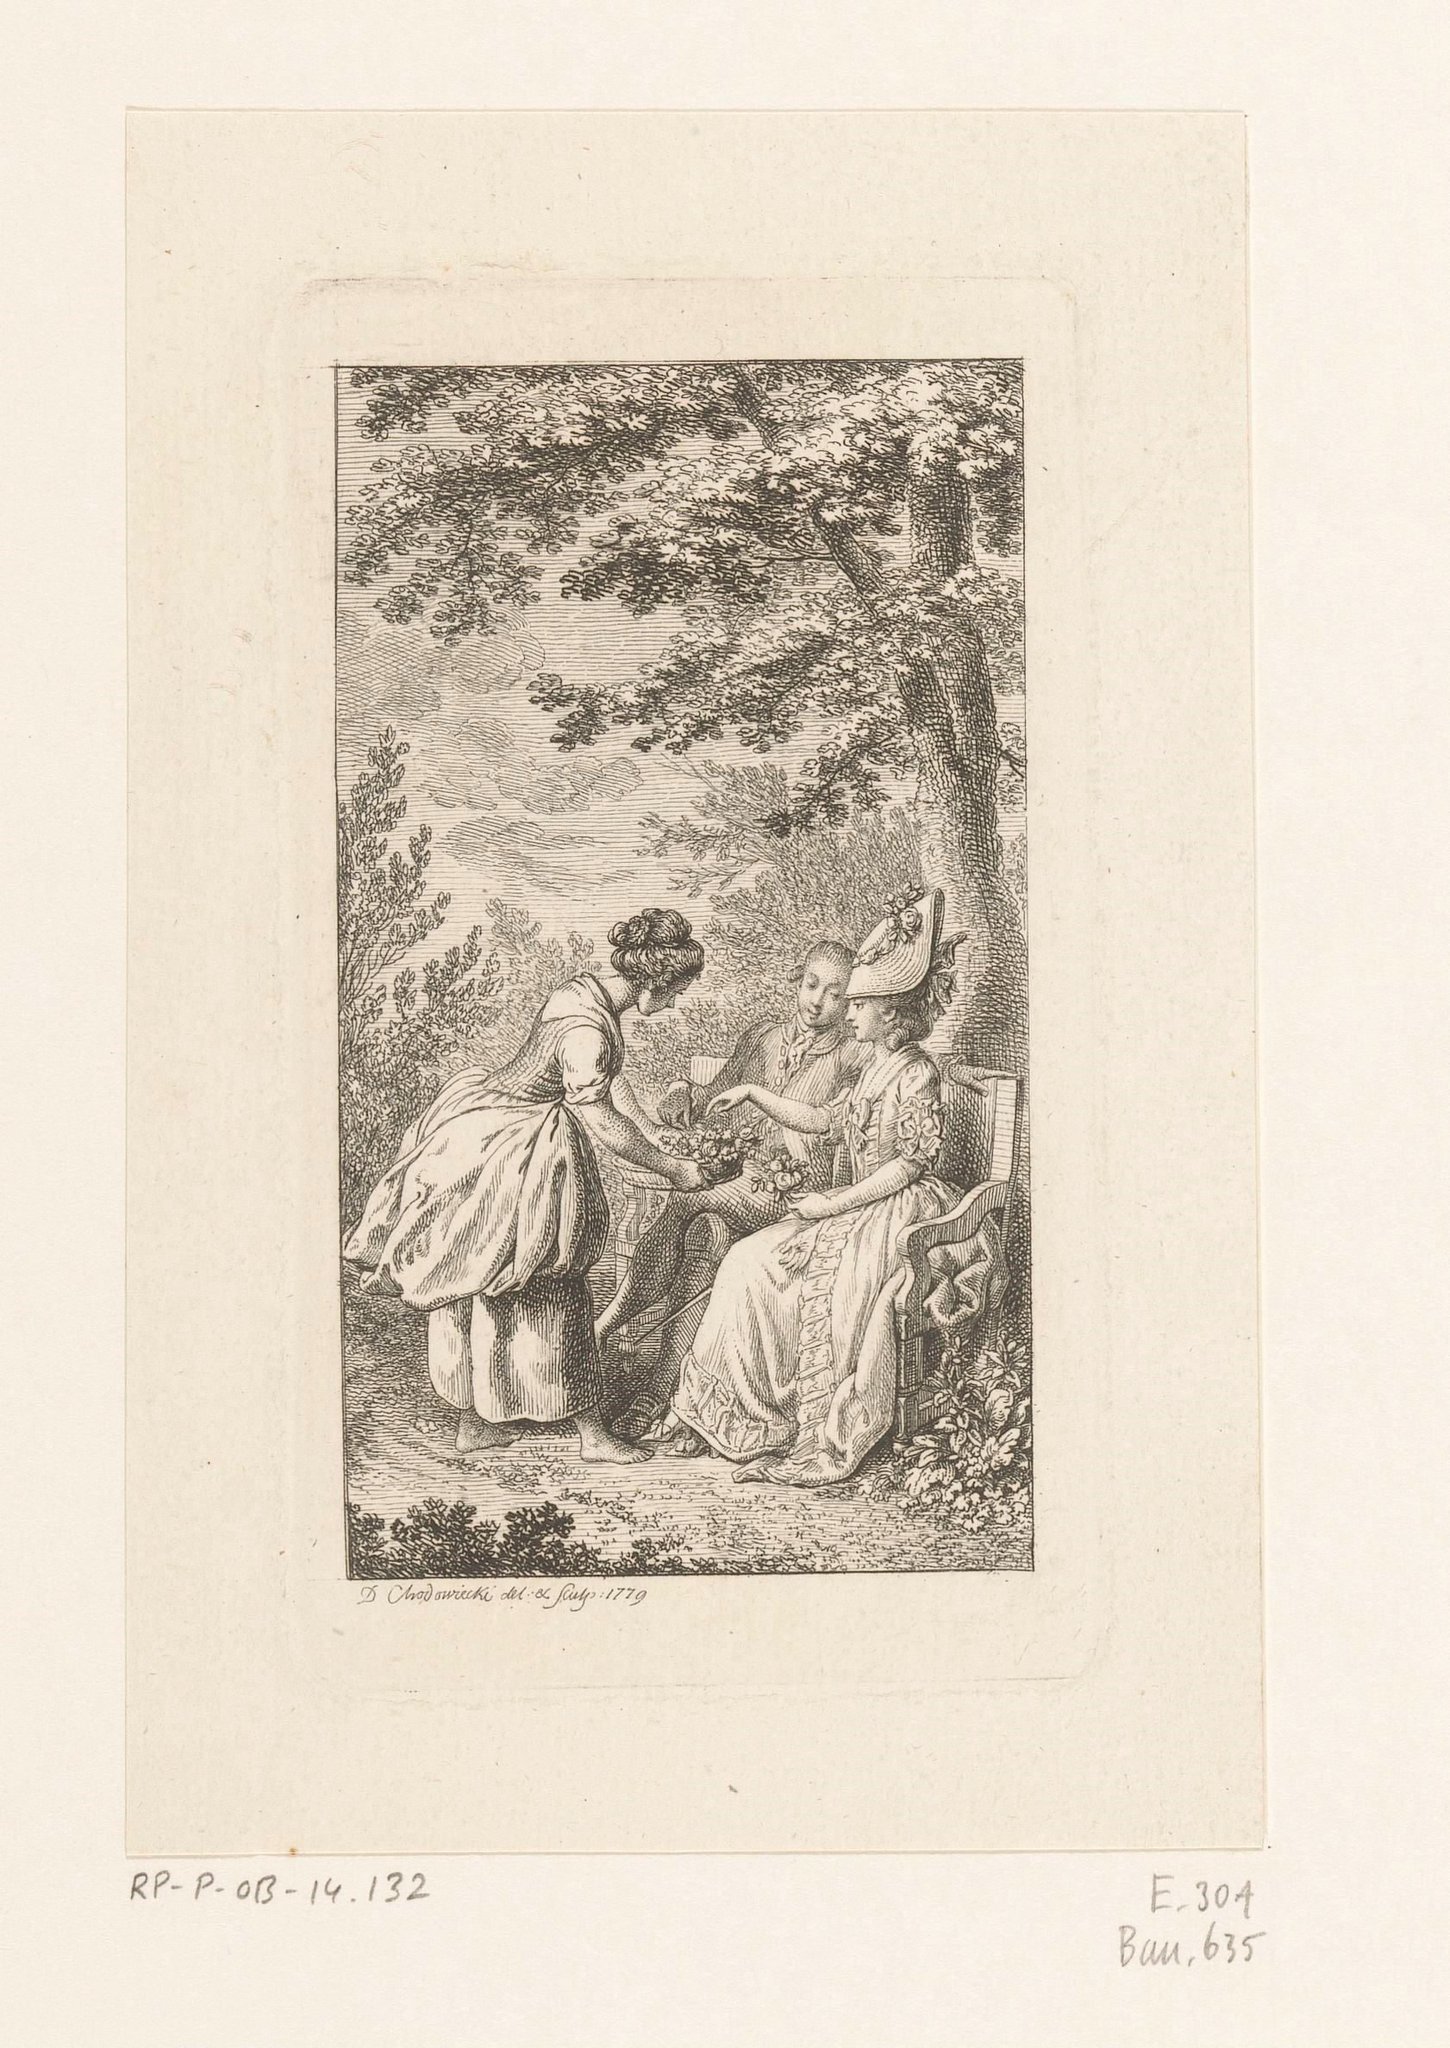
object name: print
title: Man en vrouw krijgen bloemen aangeboden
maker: daniel nikolaus chodowiecki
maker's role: draughtsman, print maker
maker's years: 1726-1801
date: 1779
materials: paper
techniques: etching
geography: berlin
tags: cut flowers; nosegay, bunch of flowers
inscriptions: collector's mark: Lugt 2228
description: Prent ook gebruikt in: Sammlung witziger Einfälle kleiner scherzhafter Erzählungen und Sinngedichte. Besonders für Kinder und junge Leute. Berlijn: August Mylius, 1779.